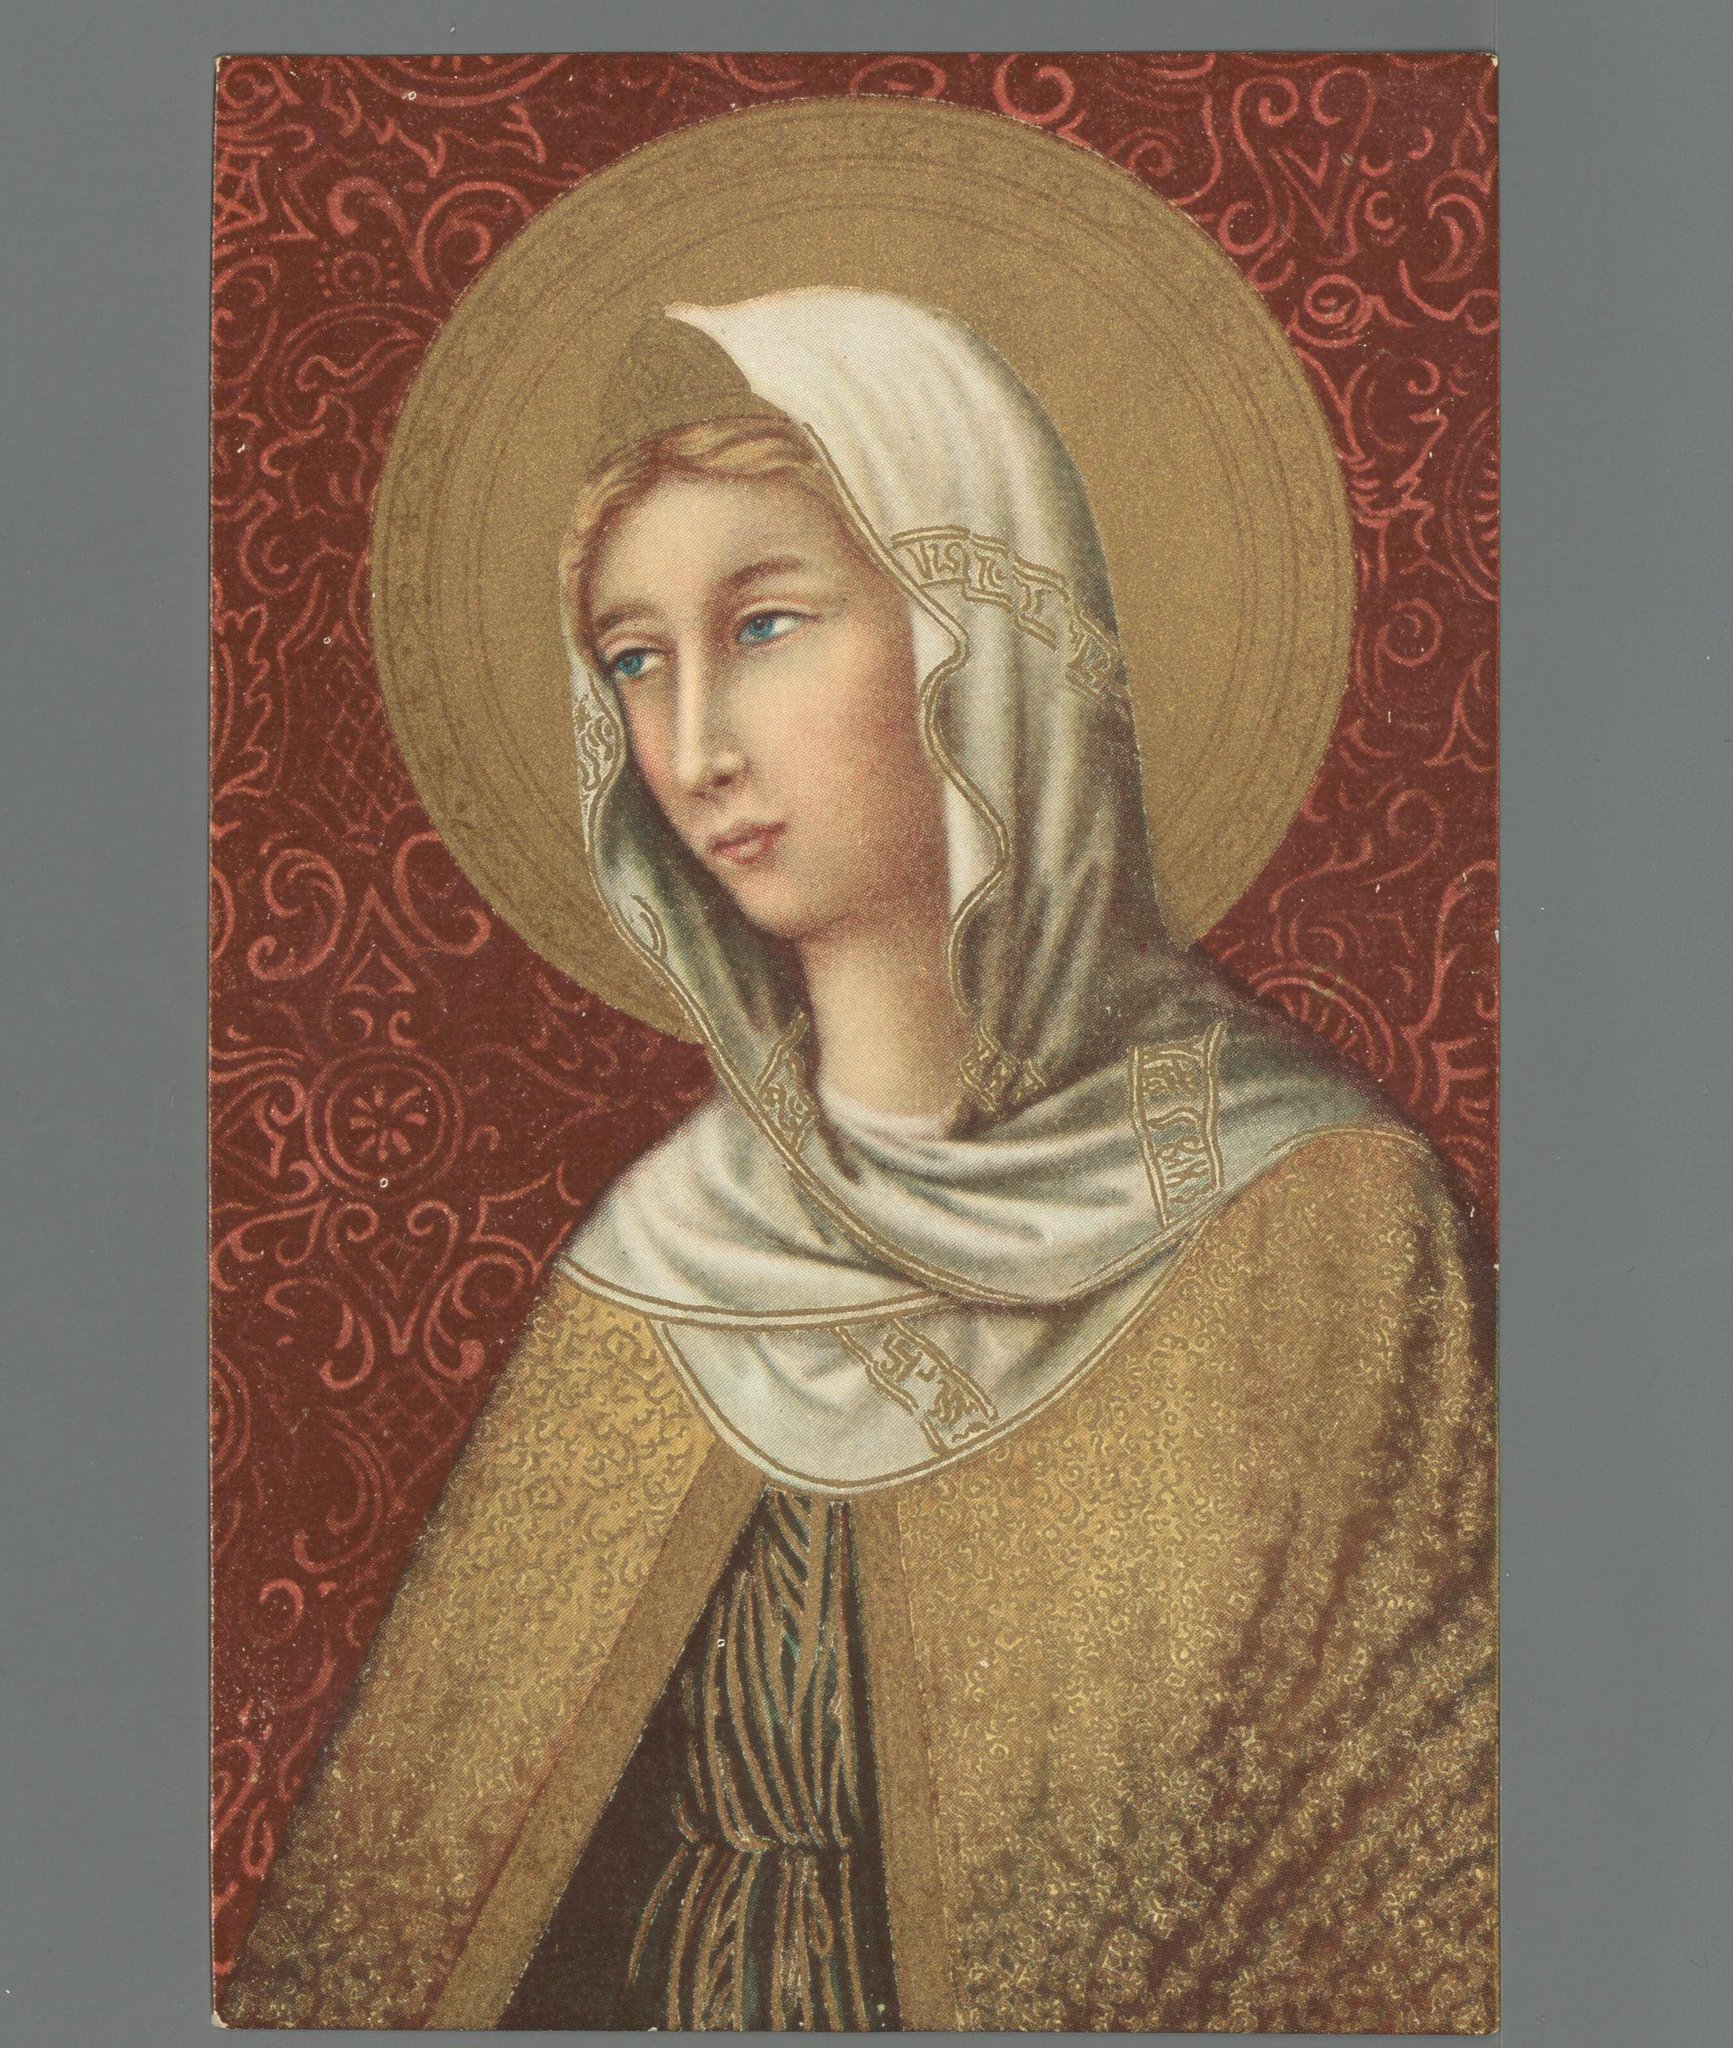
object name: ansichtkaart, prentbriefkaart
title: S. Agnese. Particolare del quadro <La Madonna e Santi>. Siena. Duccio di Boninsegna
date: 1906-1930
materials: cardboard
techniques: color autotype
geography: italy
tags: interior of church, picture, painting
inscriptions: collector's mark: ‘AFE v S’